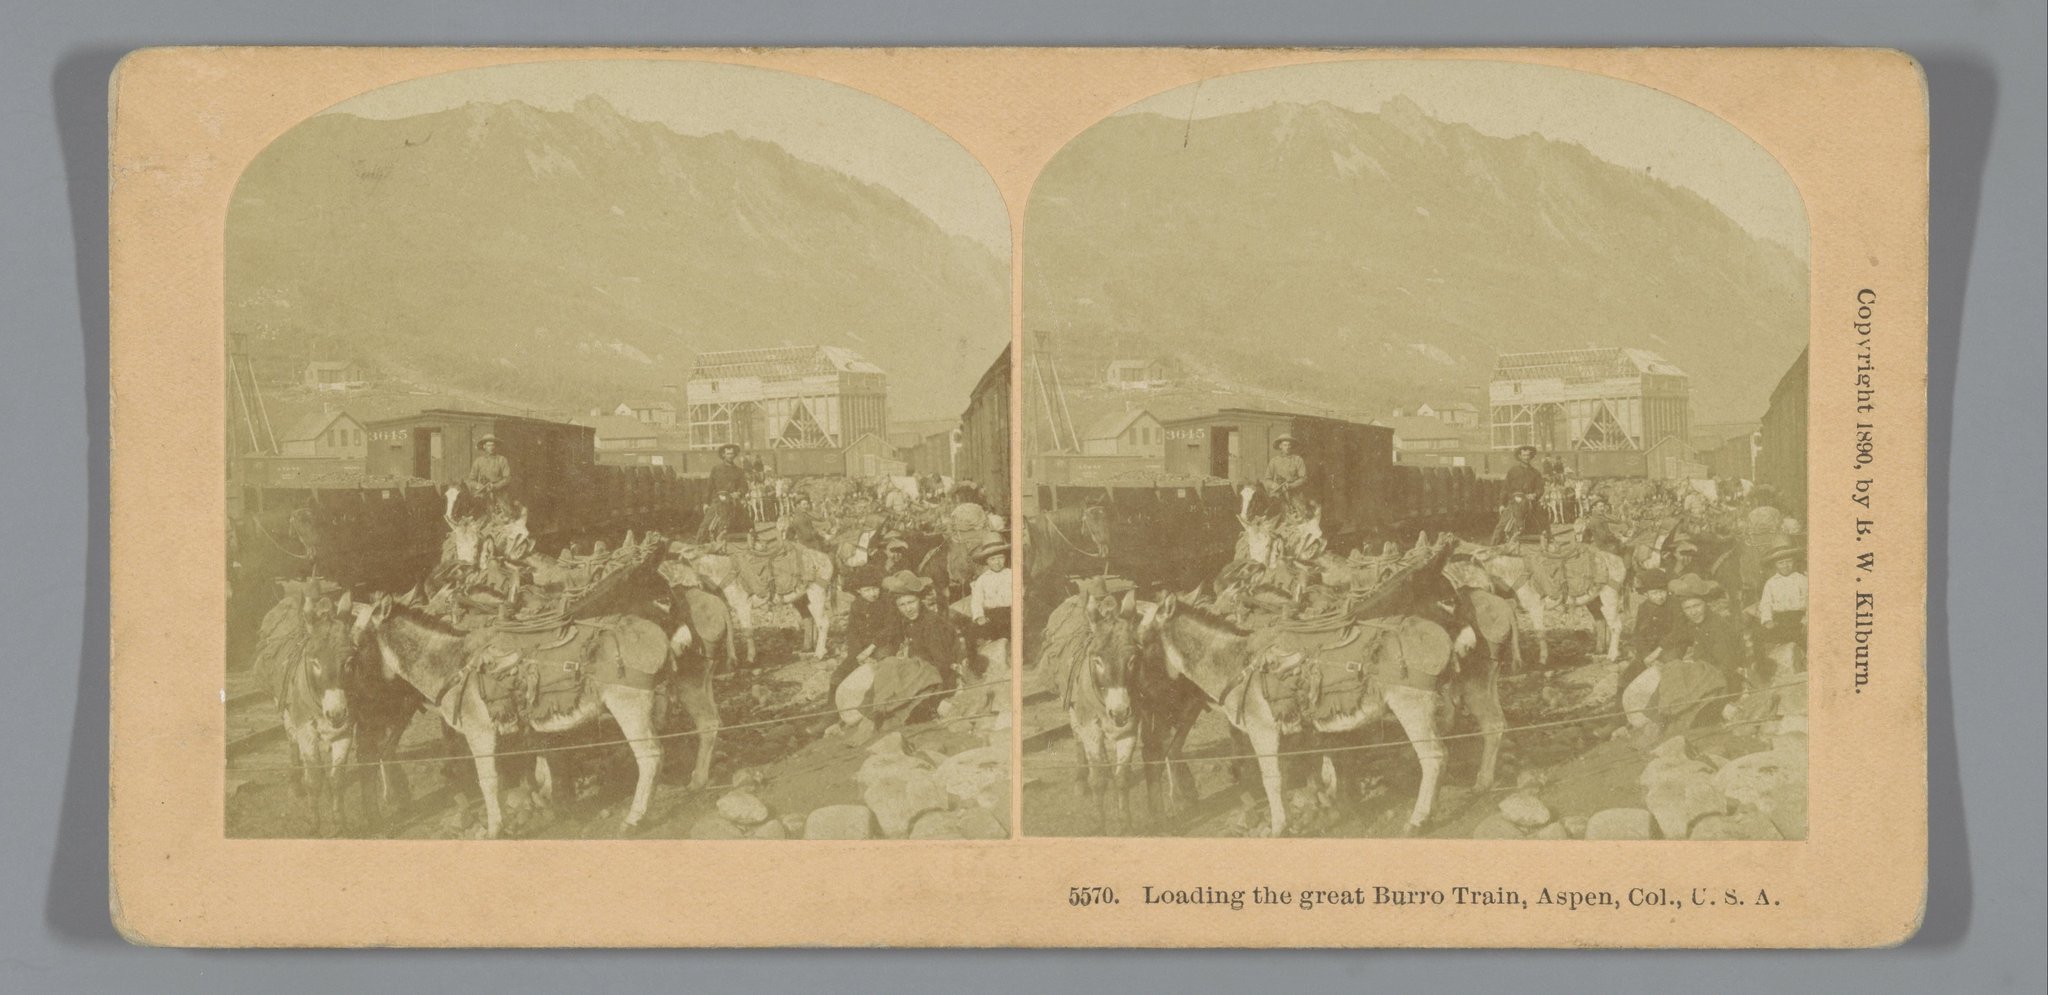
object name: stereograph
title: Ezels beladen met mijnbouw gereedschappen in Aspen, Colorado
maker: benjamin west kilburn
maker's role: fotograaf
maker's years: 1827-1909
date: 1890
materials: cardboard, paper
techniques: albumen print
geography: aspen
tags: ass, donkey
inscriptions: copyright notice: ‘Copyright 1890, by B. W. Kilburn.’